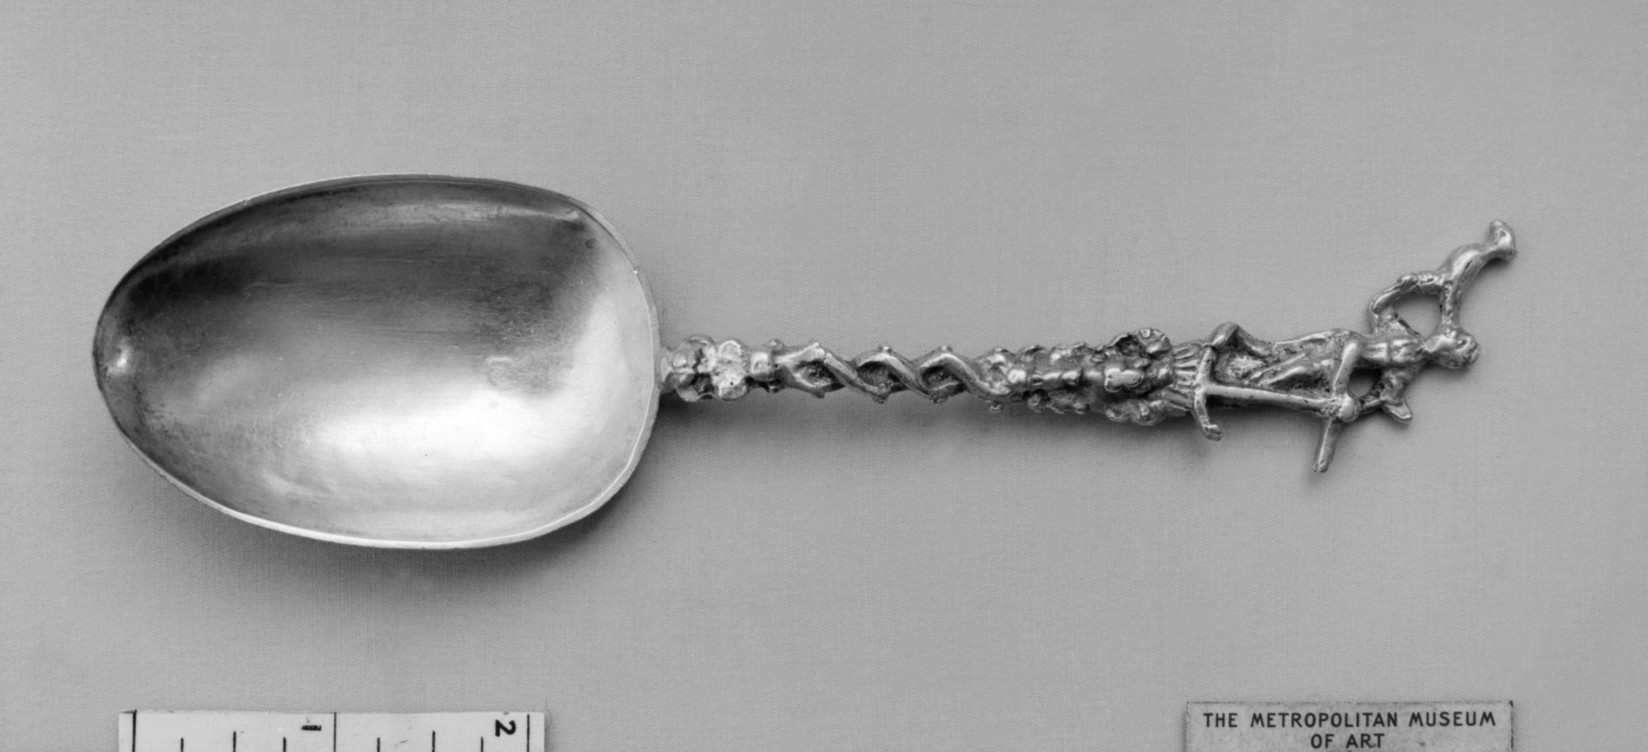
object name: spoon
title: Figure-top spoon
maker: philippus roorda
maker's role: maker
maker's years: 1732-1793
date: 1768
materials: silver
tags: human figures,musical instruments,swords